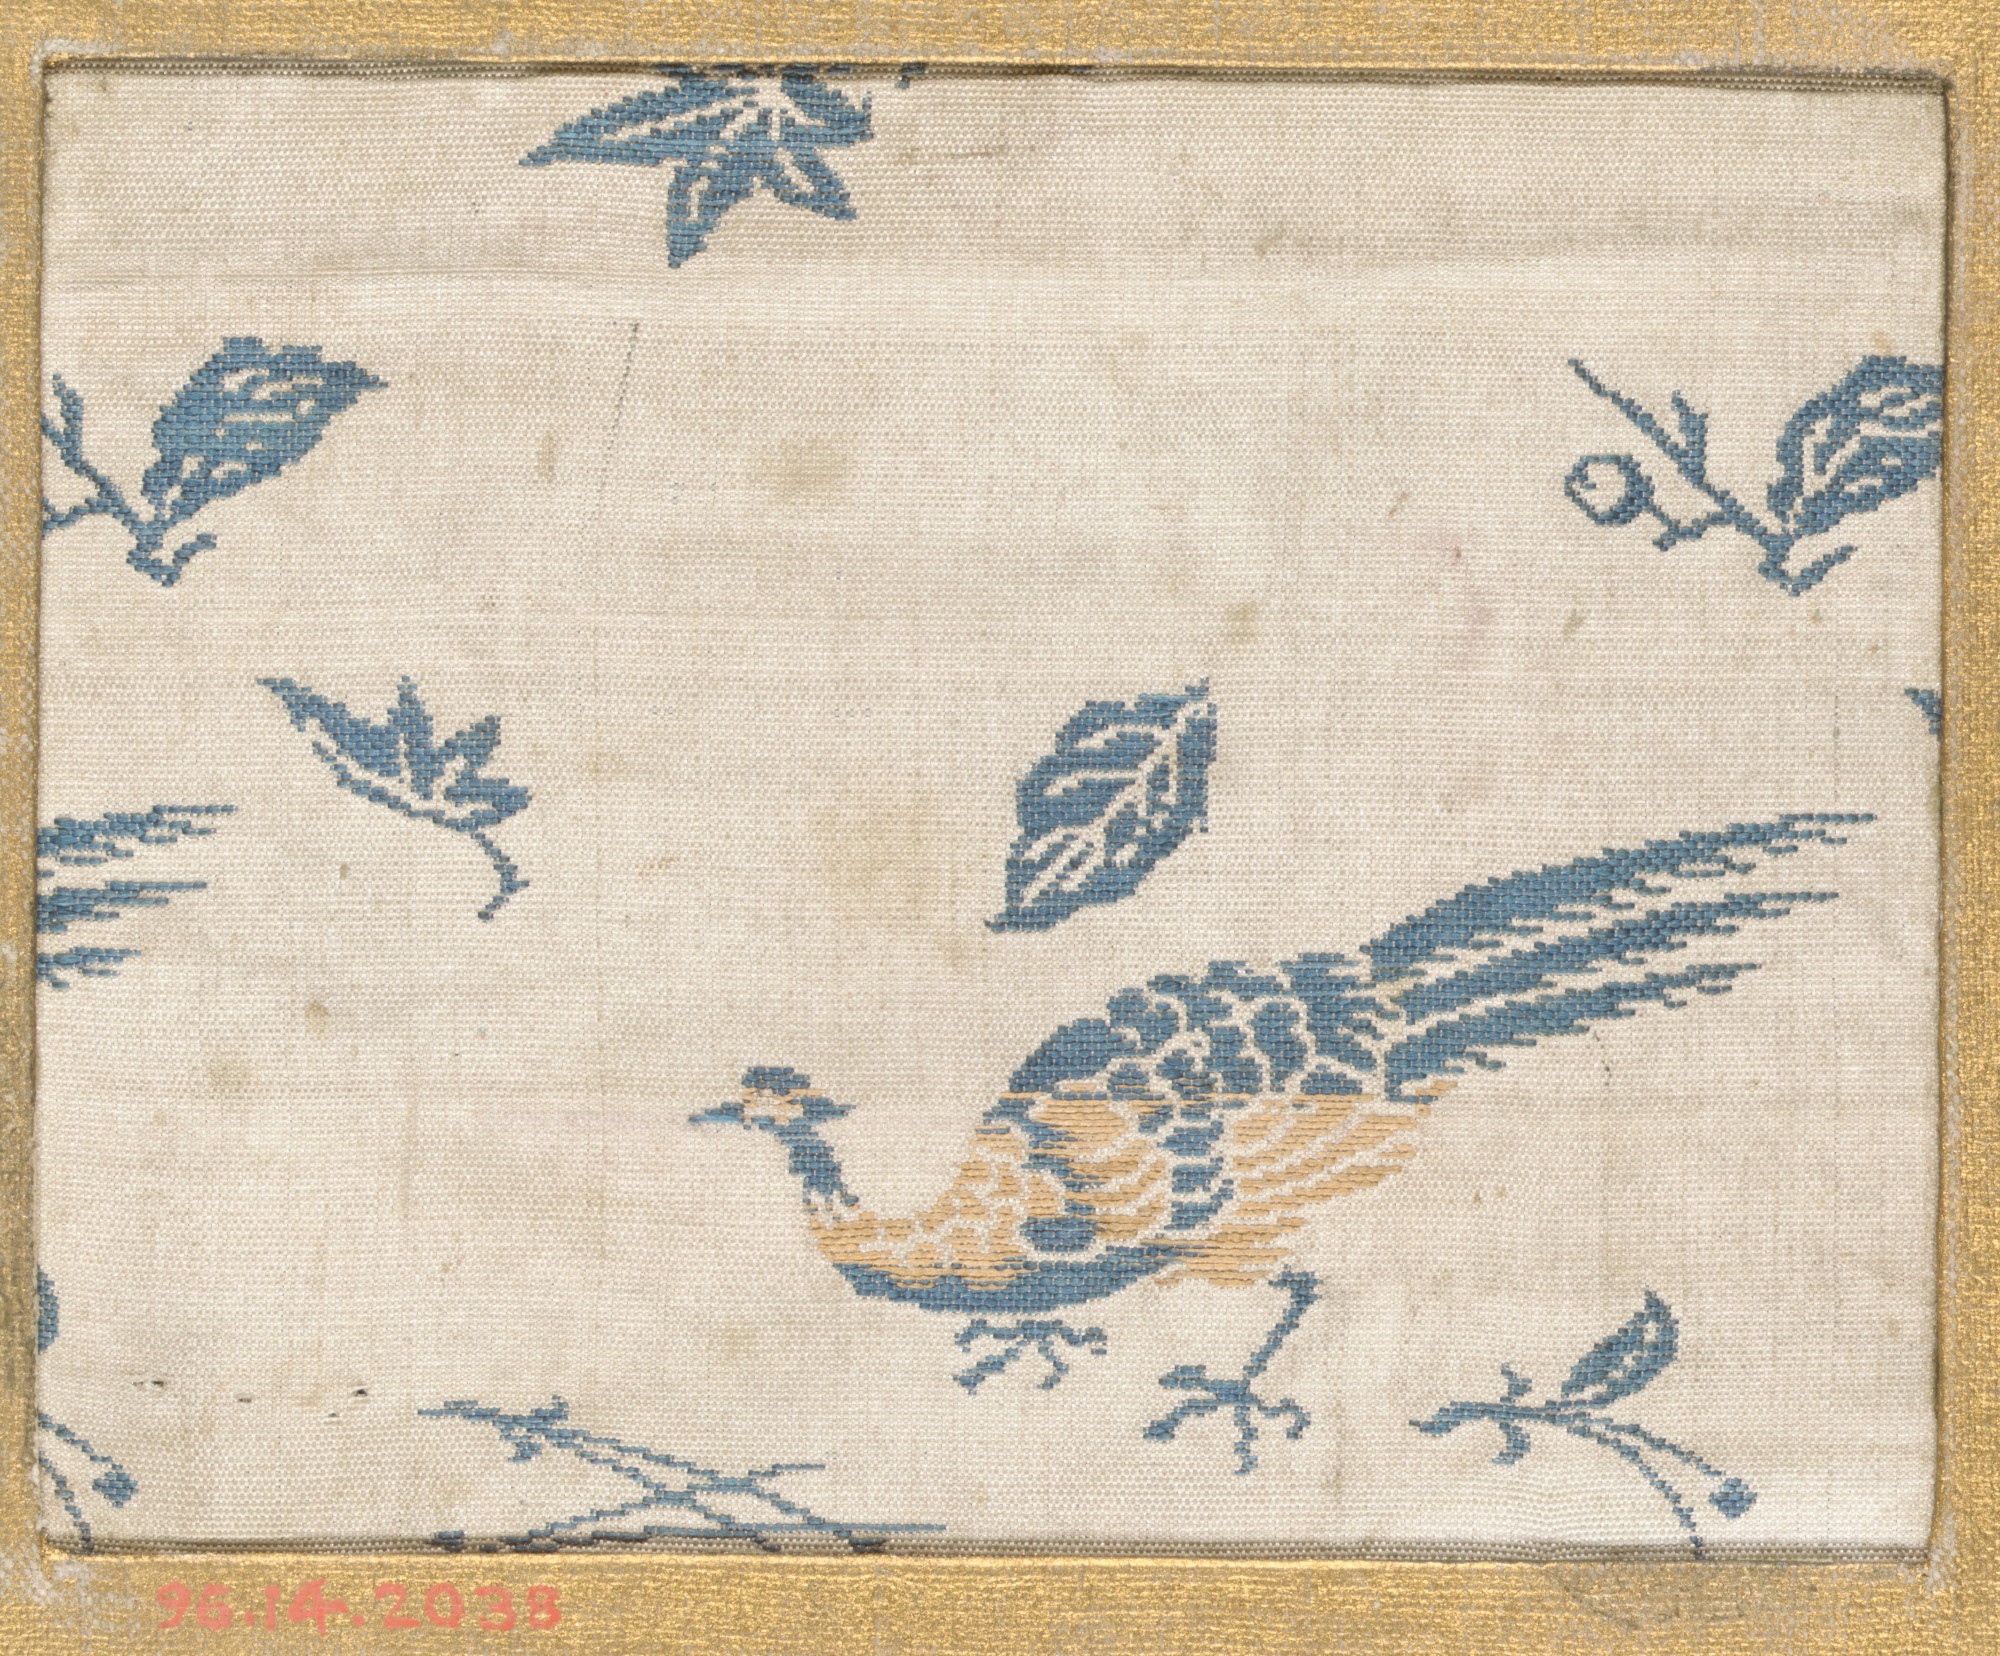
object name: piece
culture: japanese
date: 1701-1900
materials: silk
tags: leaves